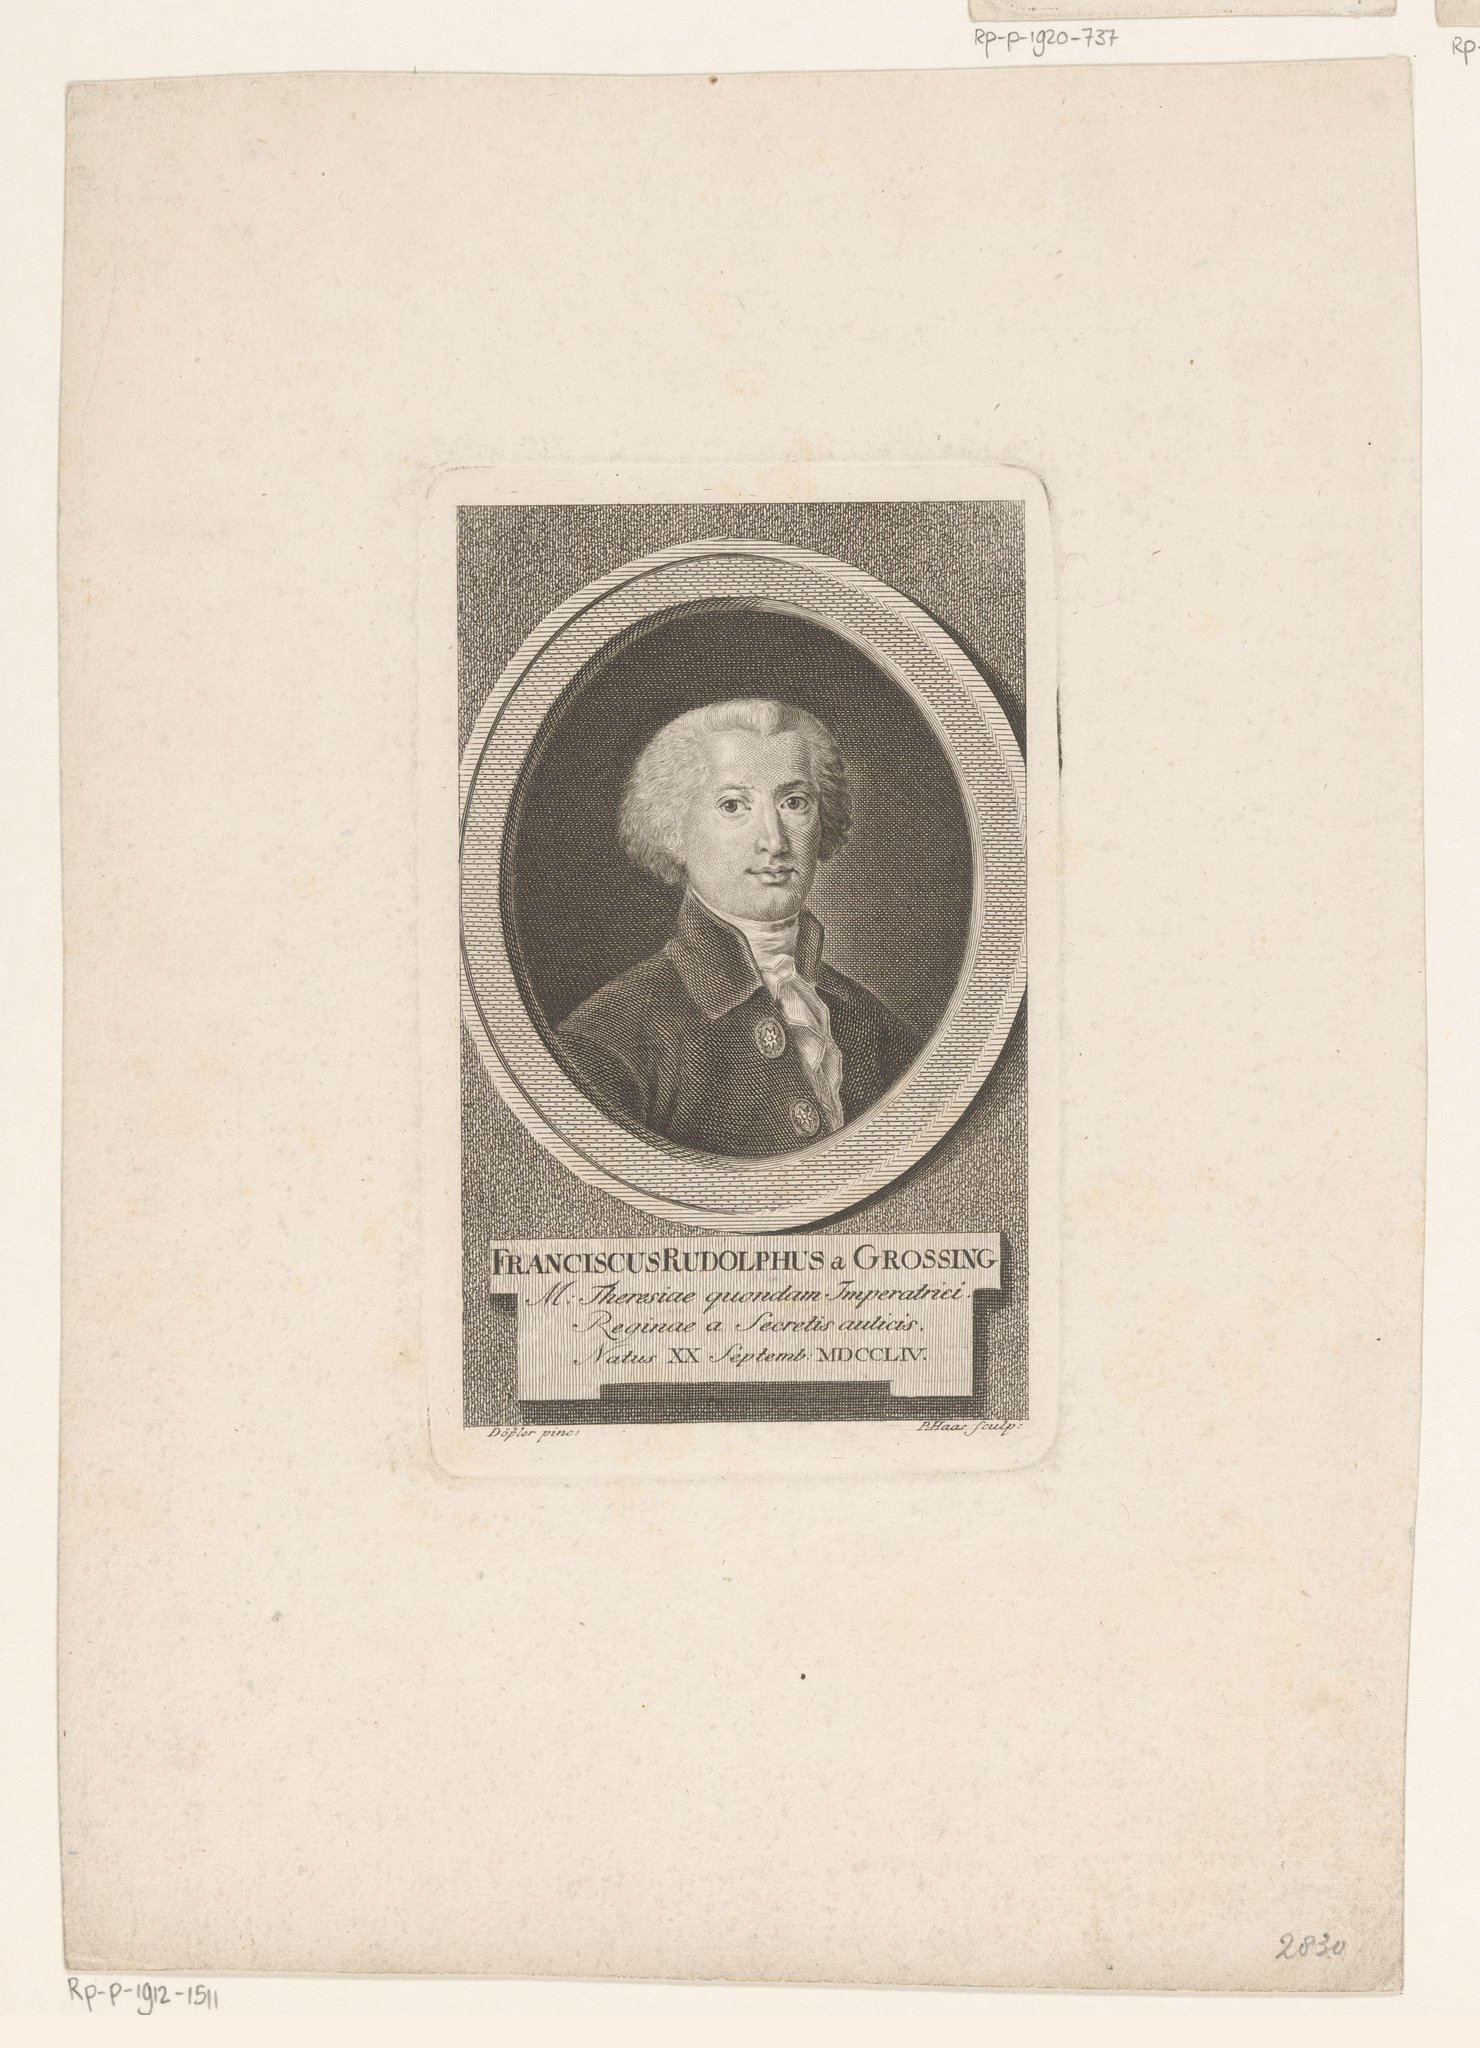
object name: print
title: Portret van Franz Rudolph von Grossing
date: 1764-1804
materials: paper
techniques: engraving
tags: historical persons, portrait of a writer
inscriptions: collector's mark: Lugt 2228